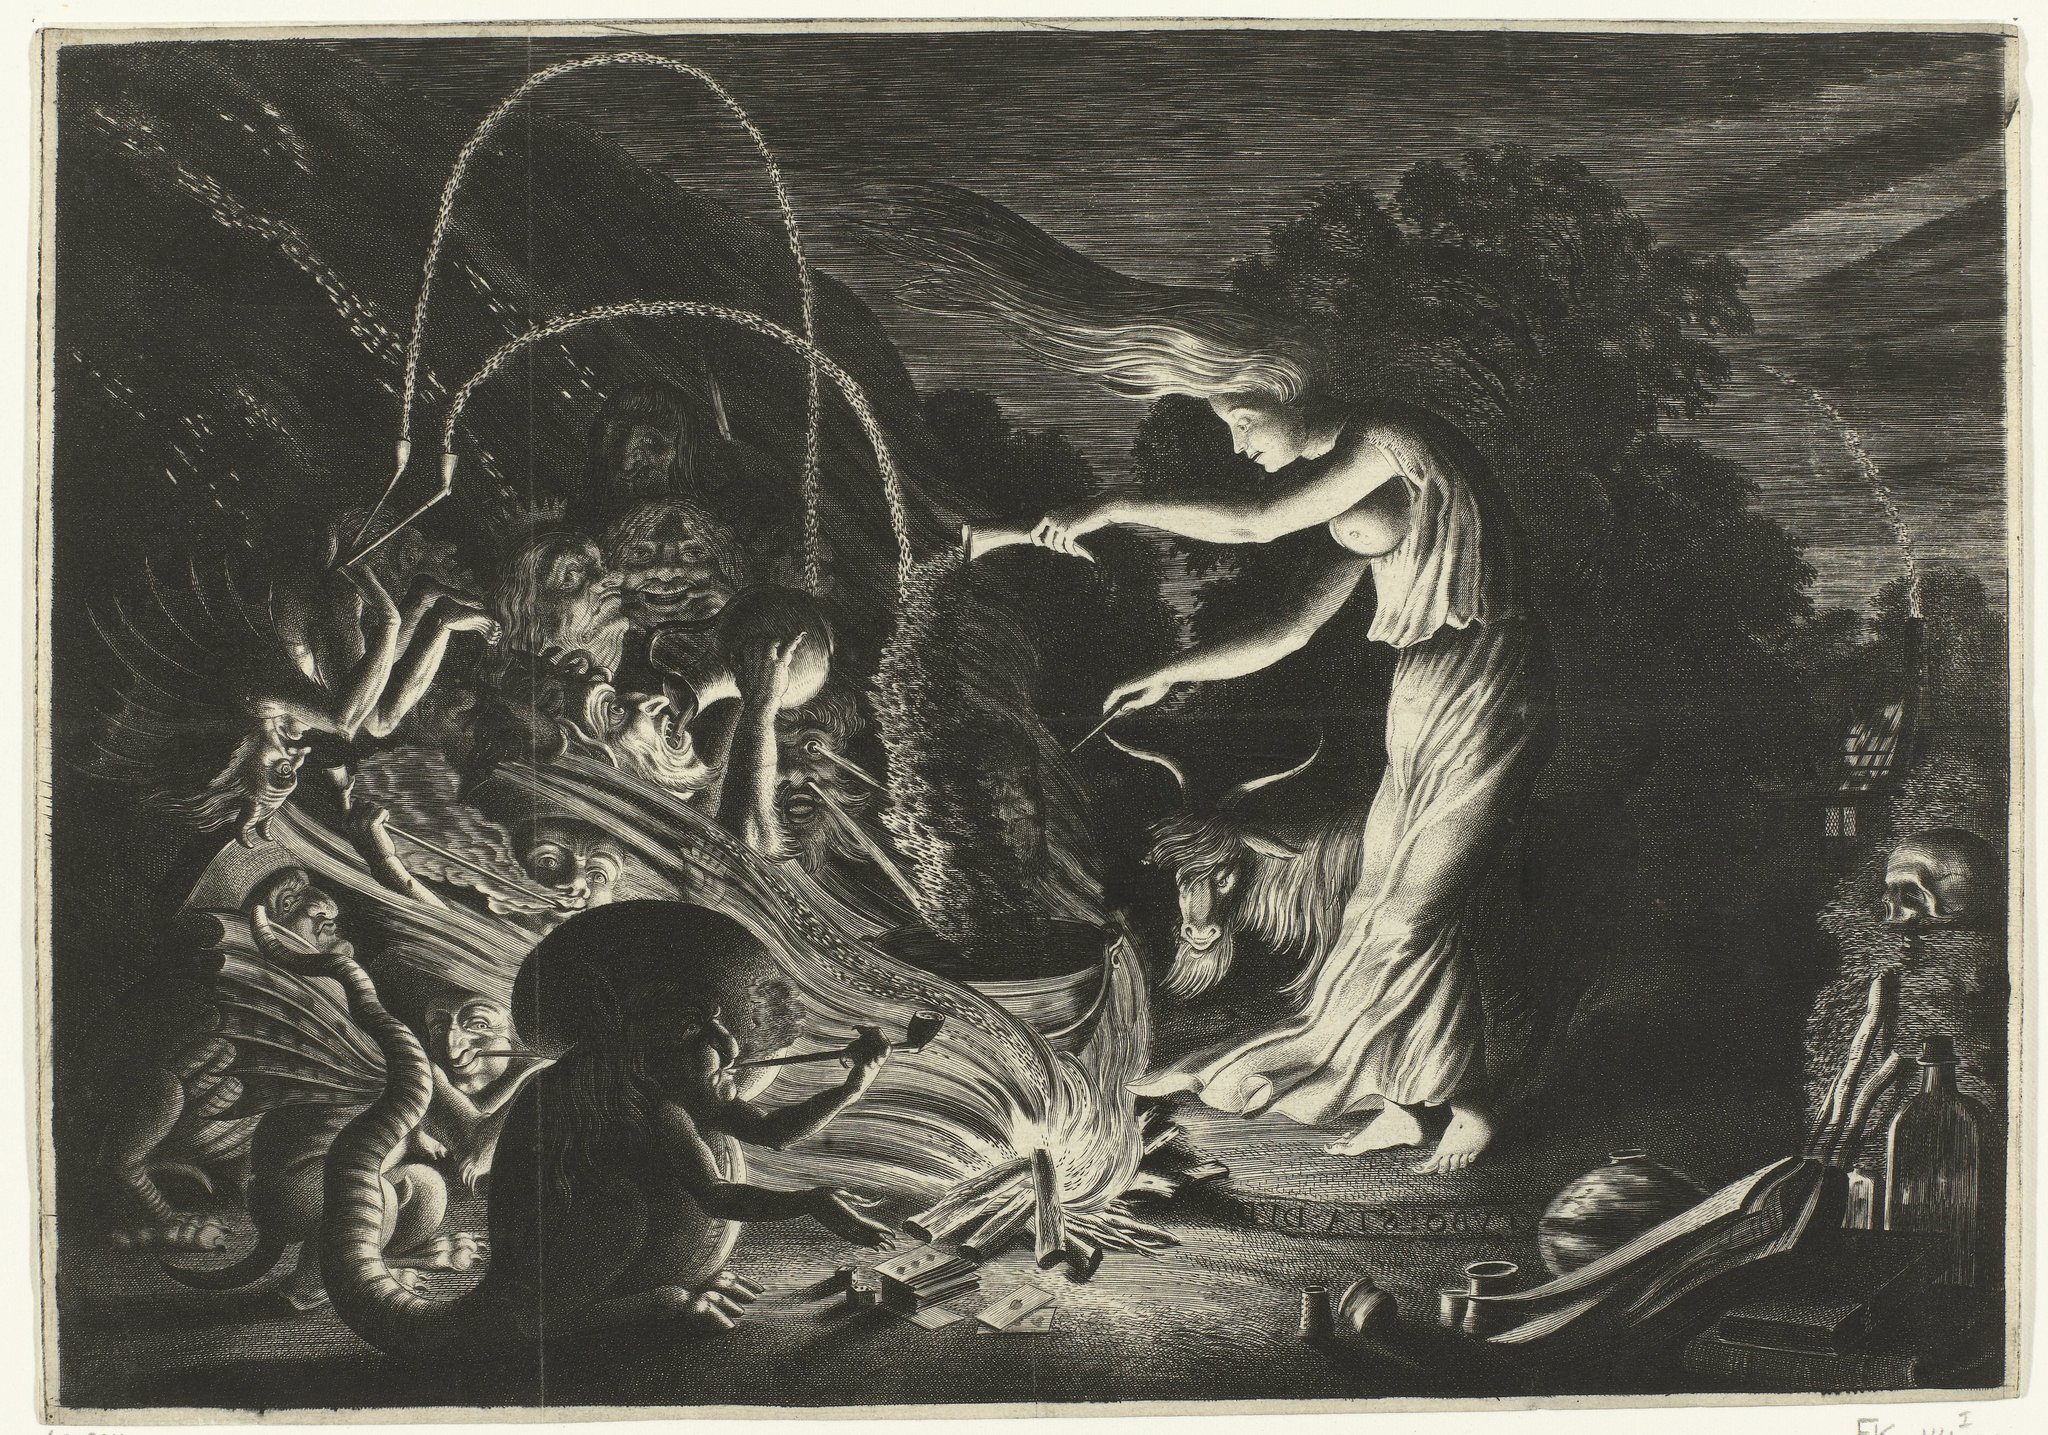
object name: print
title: Heks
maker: jan van de velde (ii)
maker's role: draughtsman, painter, print maker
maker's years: 1593-1641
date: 1626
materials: paper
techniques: engraving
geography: northern netherlands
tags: chiromancy, handreading, palmistry, witches controlling the elements, e.g. raising a storm, witch, sorceress, fortune-teller ~ pleasure fair and circus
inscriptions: collector's mark: Lugt 964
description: Een heks bij een kookpot waar zij poeders in giet. Er waait een harde wind. Voor haar een groep monsters.